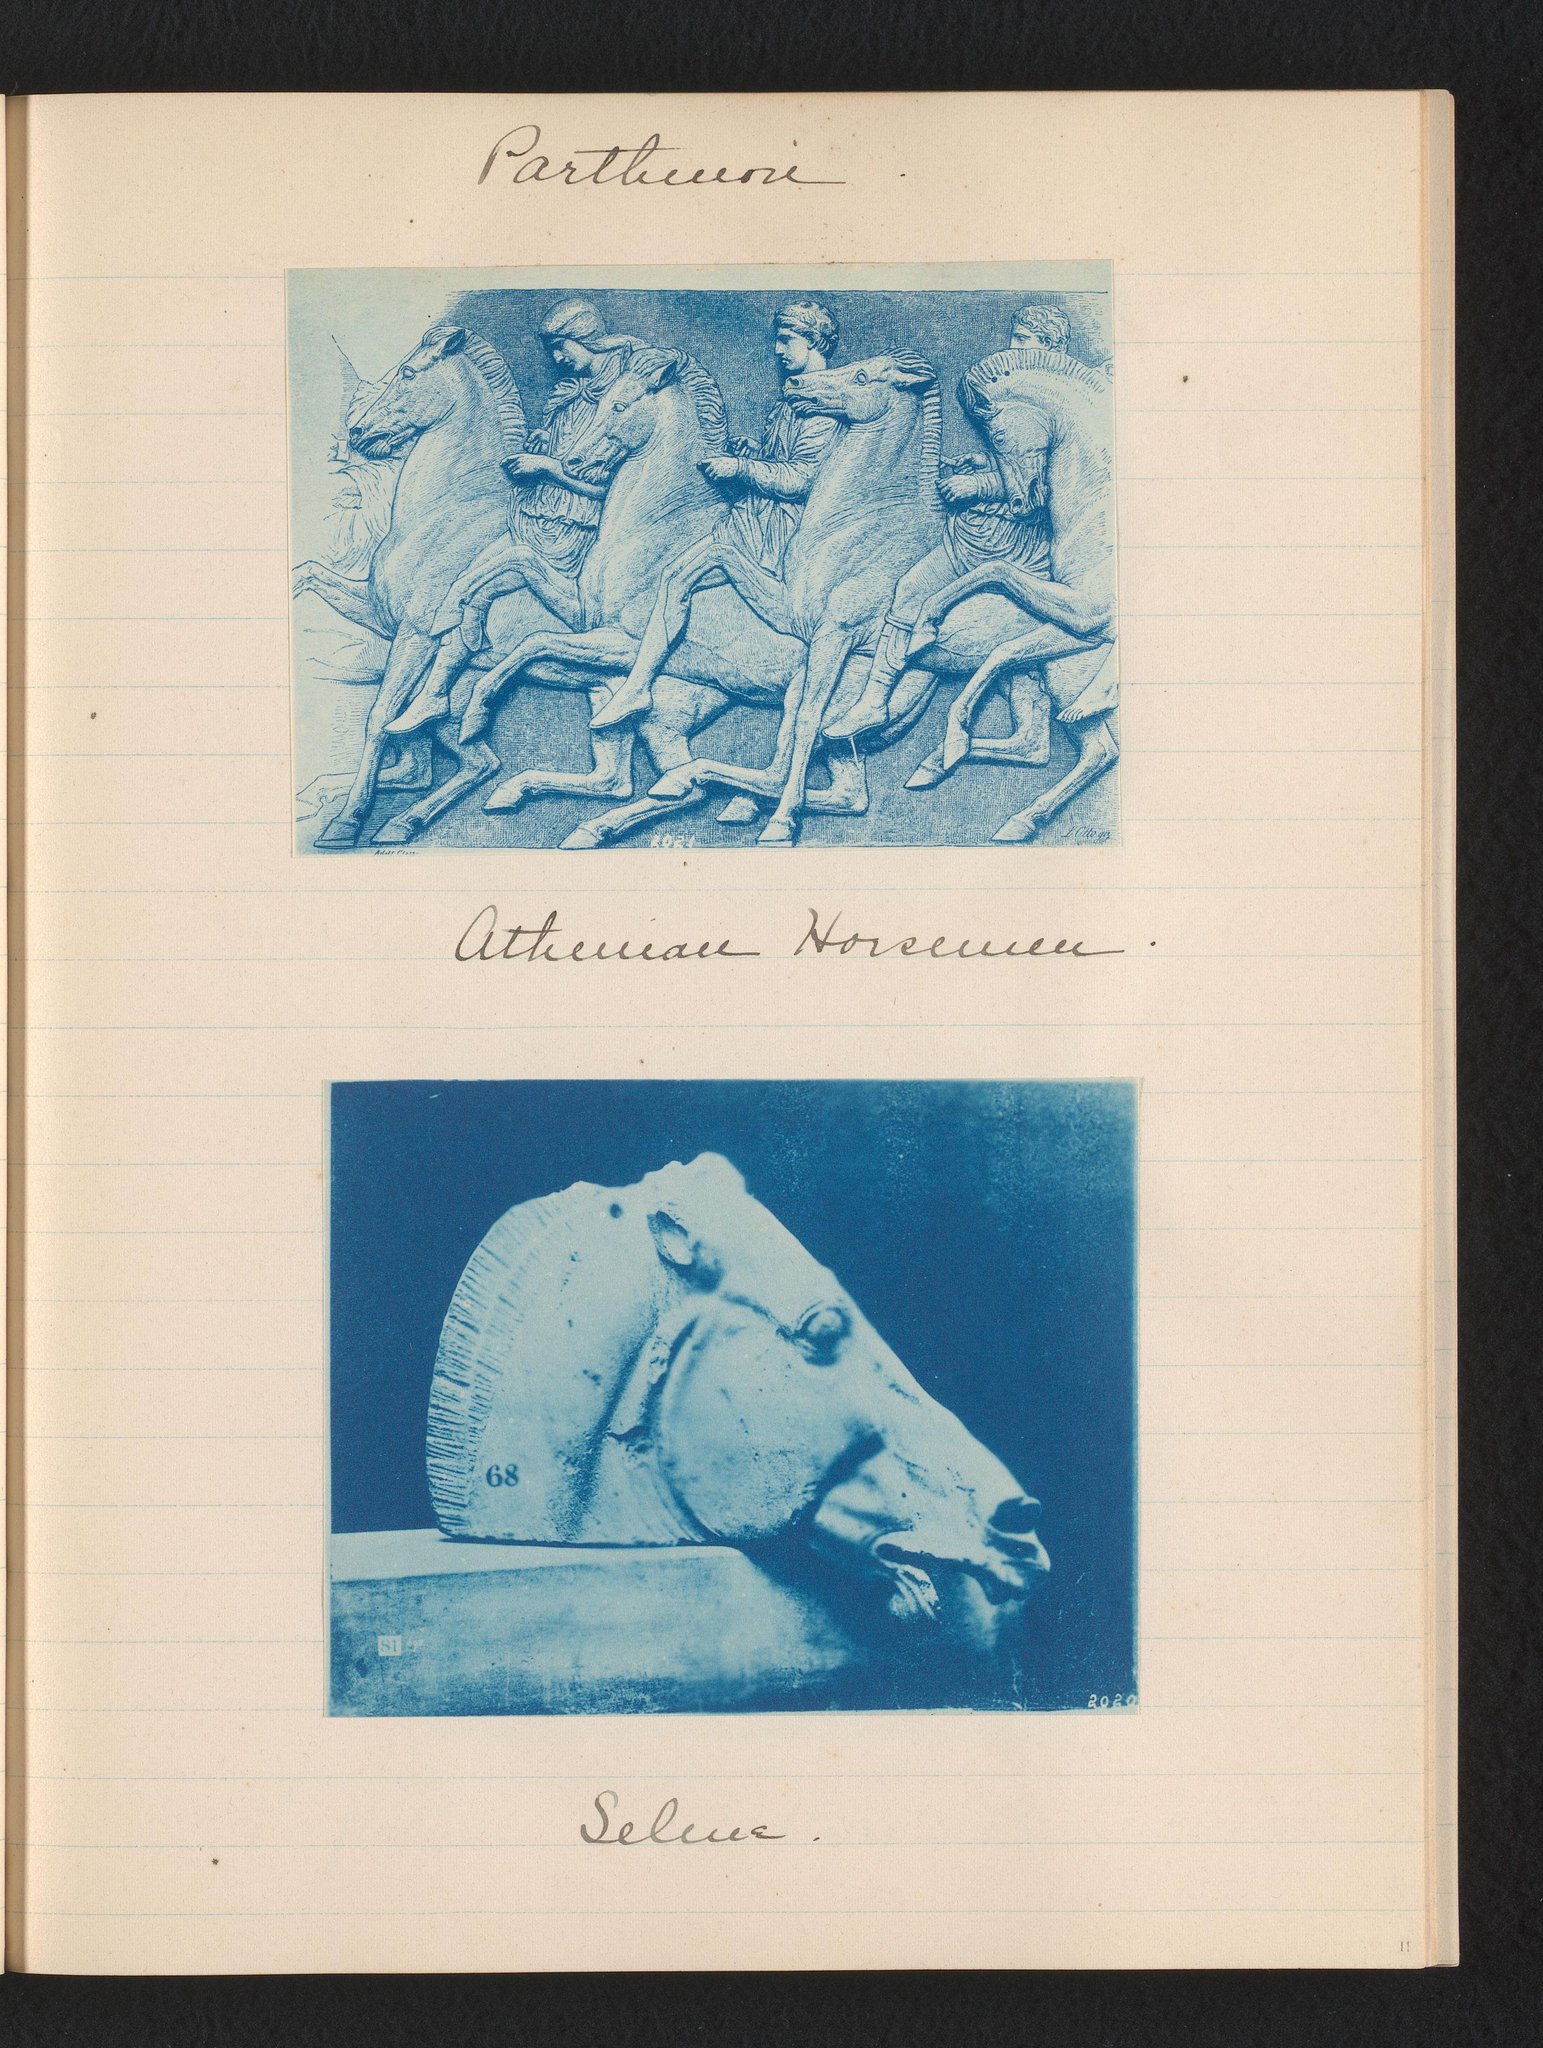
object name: photograph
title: Parthenon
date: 1901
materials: paper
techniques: cyanotype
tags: piece of sculpture, reproduction of a piece of sculpture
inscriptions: inscription: ‘Athenian Horsemen./ Selene’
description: Deze foto's maken deel uit van een album.